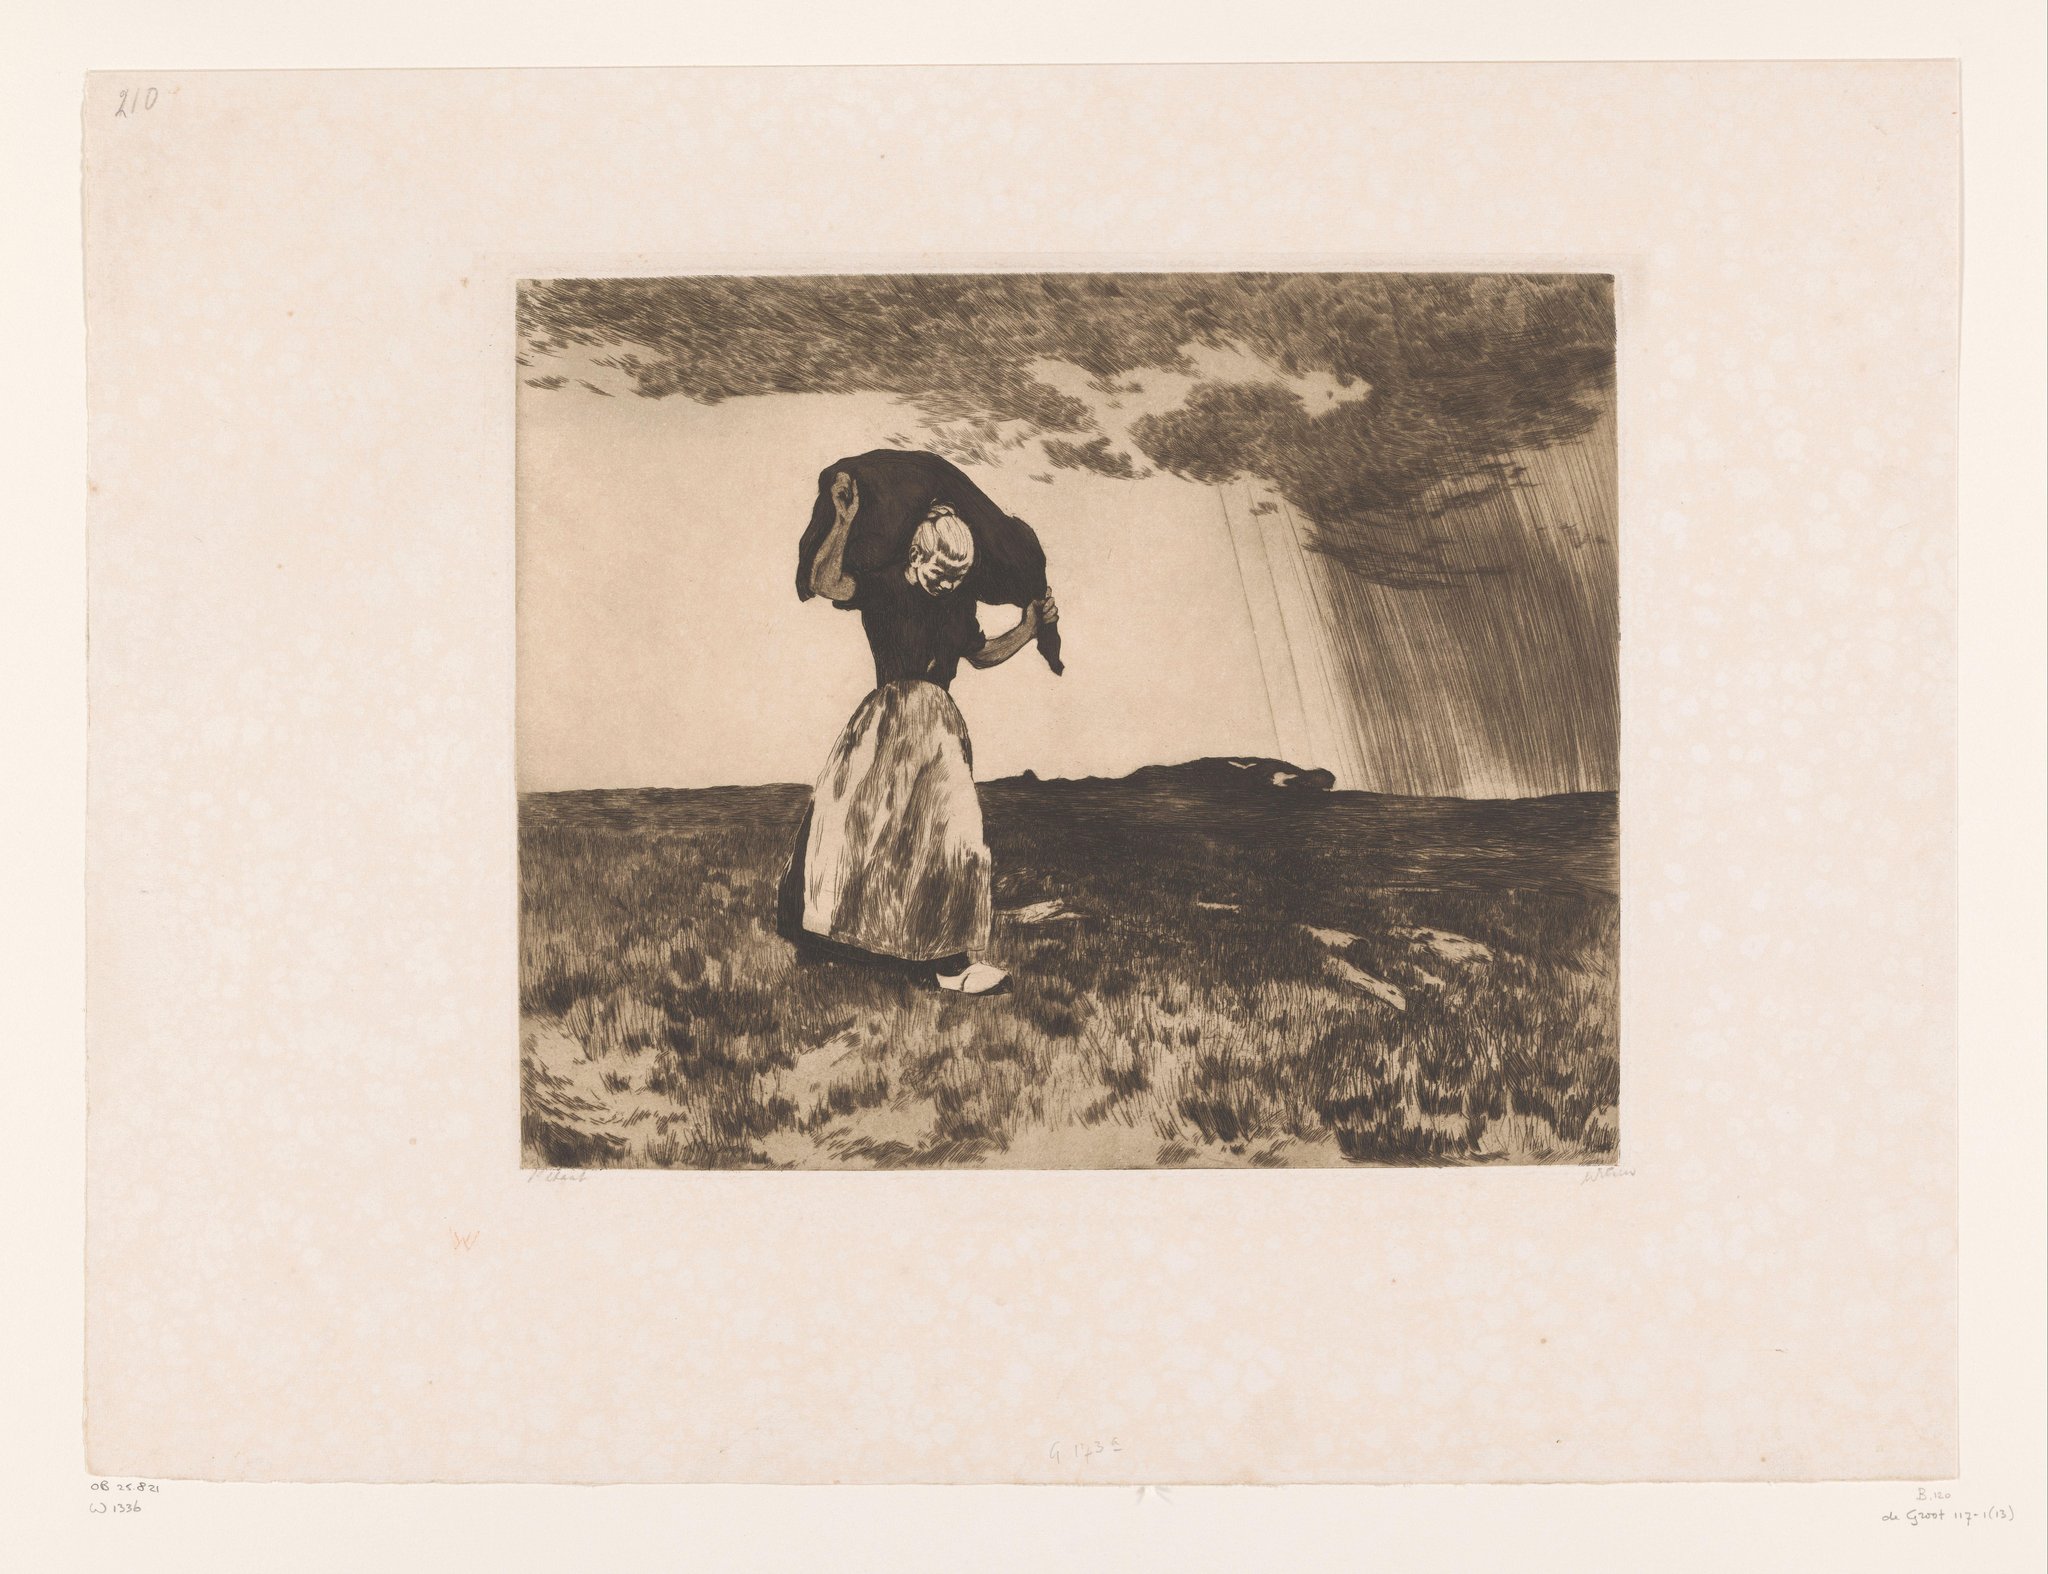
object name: print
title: Hanna in de heide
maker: willem witsen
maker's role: draughtsman, painter, print maker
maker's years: 1860-1923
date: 1906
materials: paper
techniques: aquatint, etching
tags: adult woman, storing in sacks ~ harvest, plain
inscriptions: annotation: ‘1e staat’